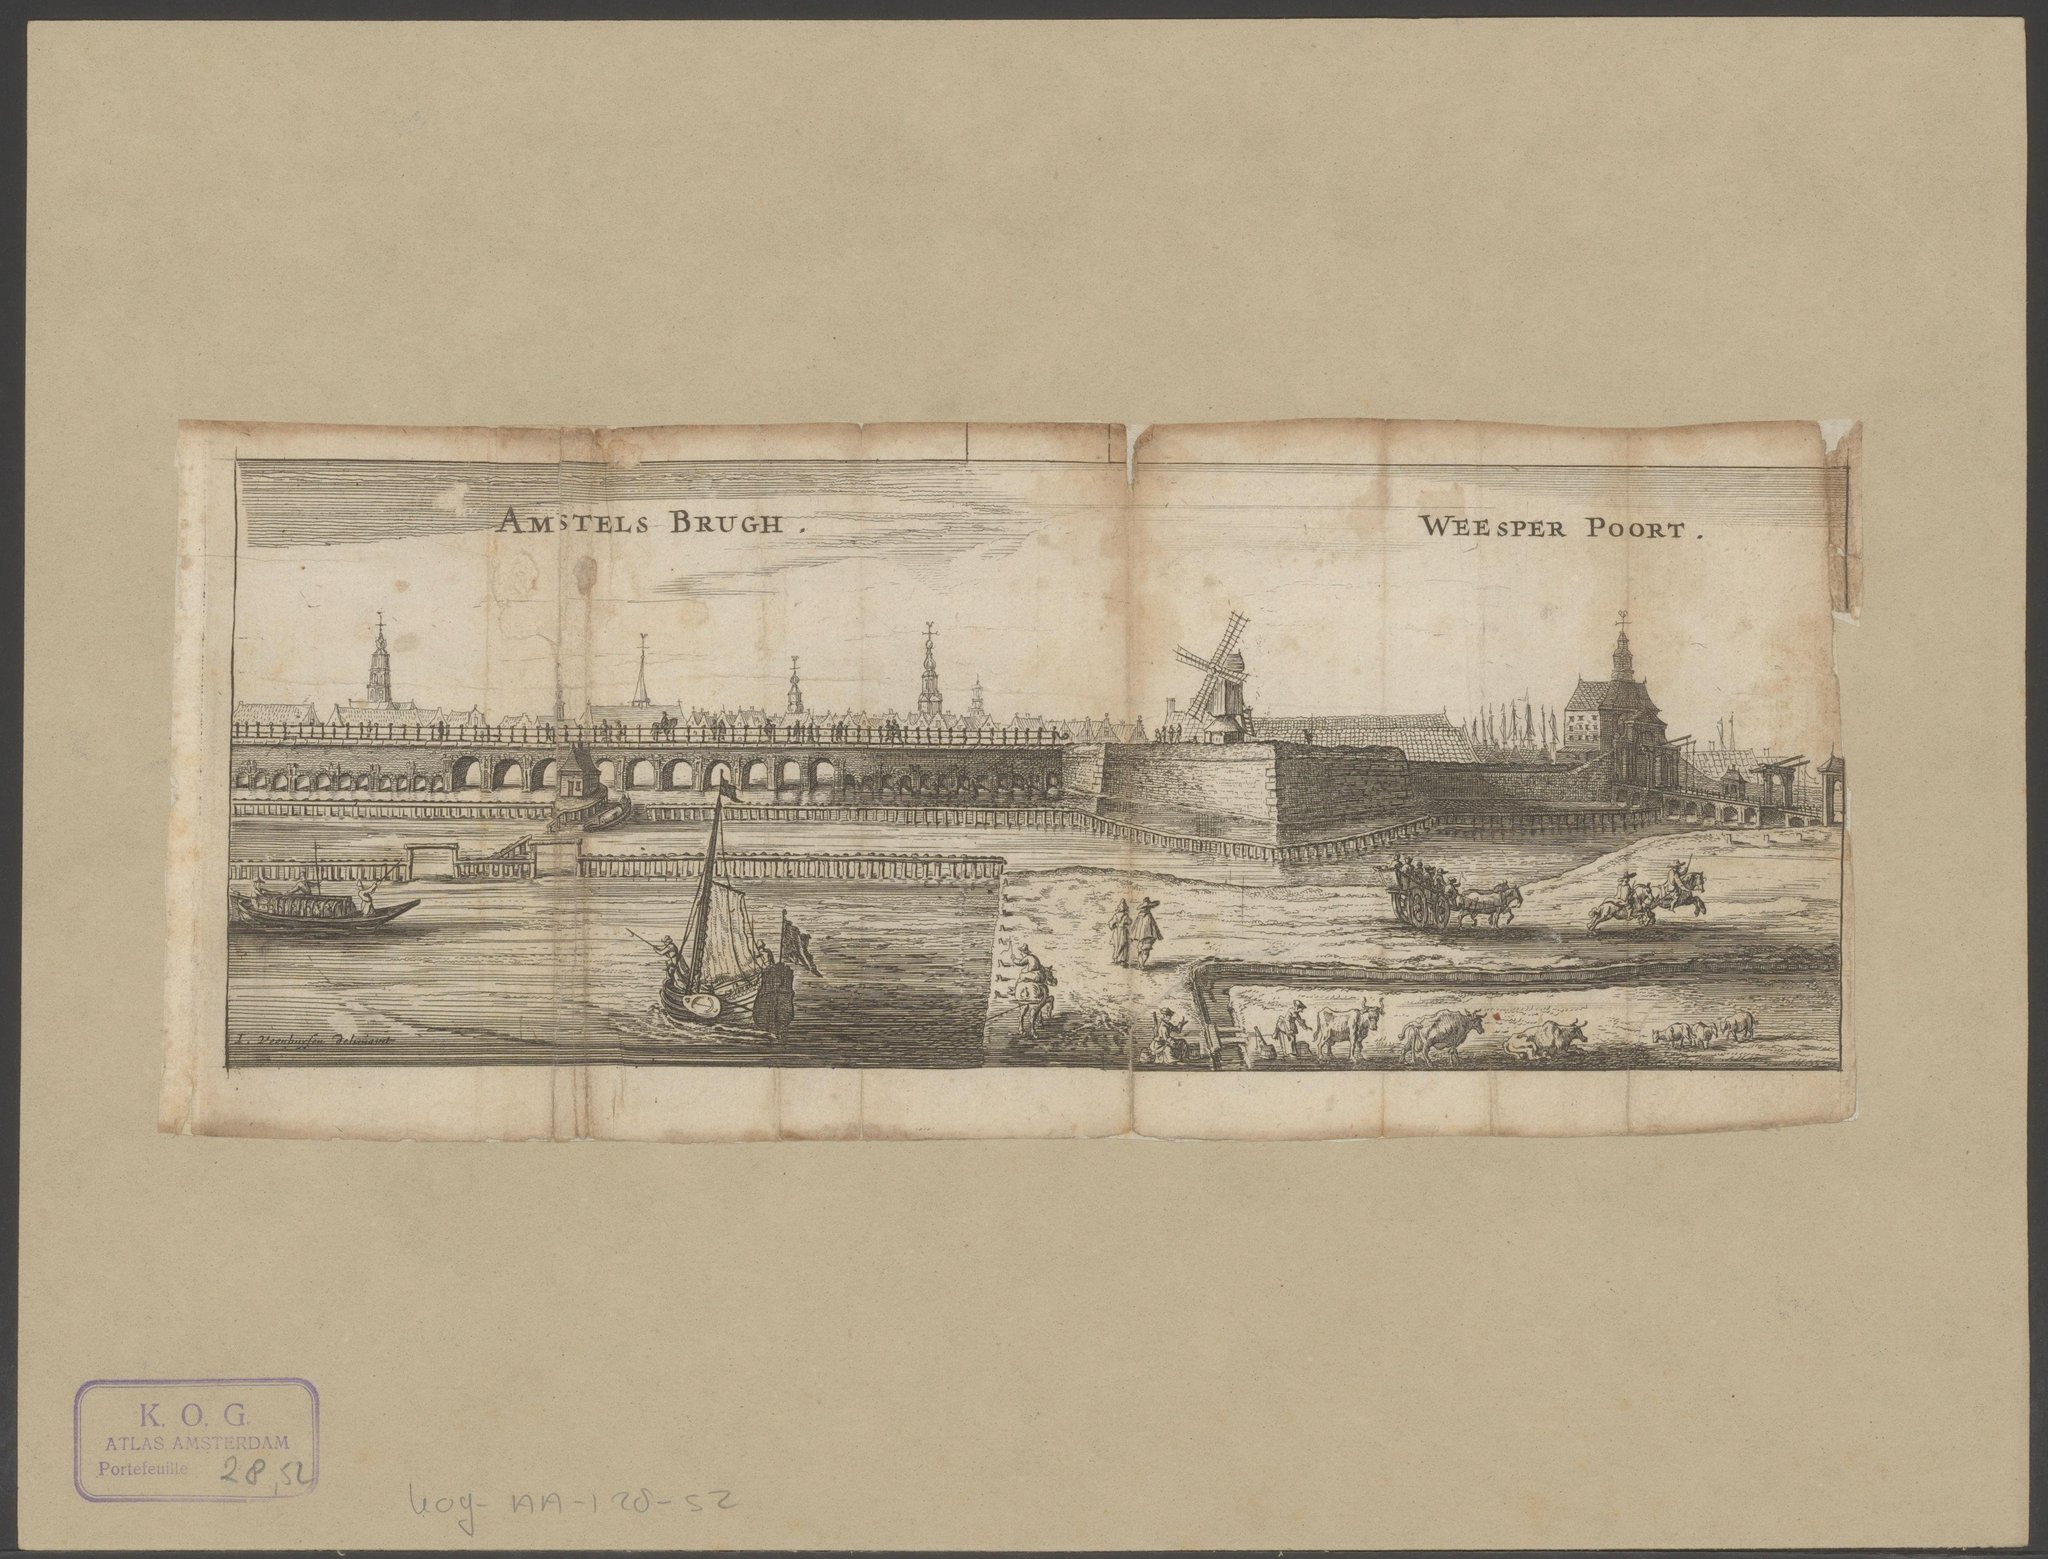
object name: print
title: Gezicht op de Amstelbrug en de Weesperpoort te Amsterdam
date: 1664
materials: paper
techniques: engraving, etching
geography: amsterdam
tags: bridge, city-gate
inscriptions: collector's mark: Lugt 1641b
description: Huidige staat van prent ook gebruikt in: Fockens, Melchior. Beschrijving Der wijdt-vermaarde Koop-stadt Amstelredam, Van haar eerste beginselen, zedert den Jare 1203. oude Voorrechten, verscheyde Vergrootingenoude Voor-rechten, en verscheyde Vergrootingen (…). 3de druk. Amsterdam: Marcus Willemsz. Doornick, 1664. En in: Zesen, Philipp von. Beschrybung der Weidtberuhmde Kauf-Stadt Amstelredam / Beschreibung der Stadt Amsterdam darinnen von derselben ersten ursprunge bis auf gegenwartigen zustand (…). Amsterdam: Marcus Willemsz. Doornick, 1664. Tweede bekende staat (met toevoeging Franse titel) ook gebruikt in: Domselaer, Tobias en Isaac Commelin. Beschryvinge van Amsterdam : haar eerste oorspronk uyt den huyze der heeren van Aemstel en Aemstellant (…). 6 dln. Amsterdam: Marcus Willemsz van Doornick, 1665. Derde bekende staat (versneden tot twee platen, Amstelbrug linksboven genummerd: 69; Weesperpoort rechtsboven genummerd: 68) ook gebruikt in verschillende latere zeventiende- en achttiende-eeuwse publicaties.